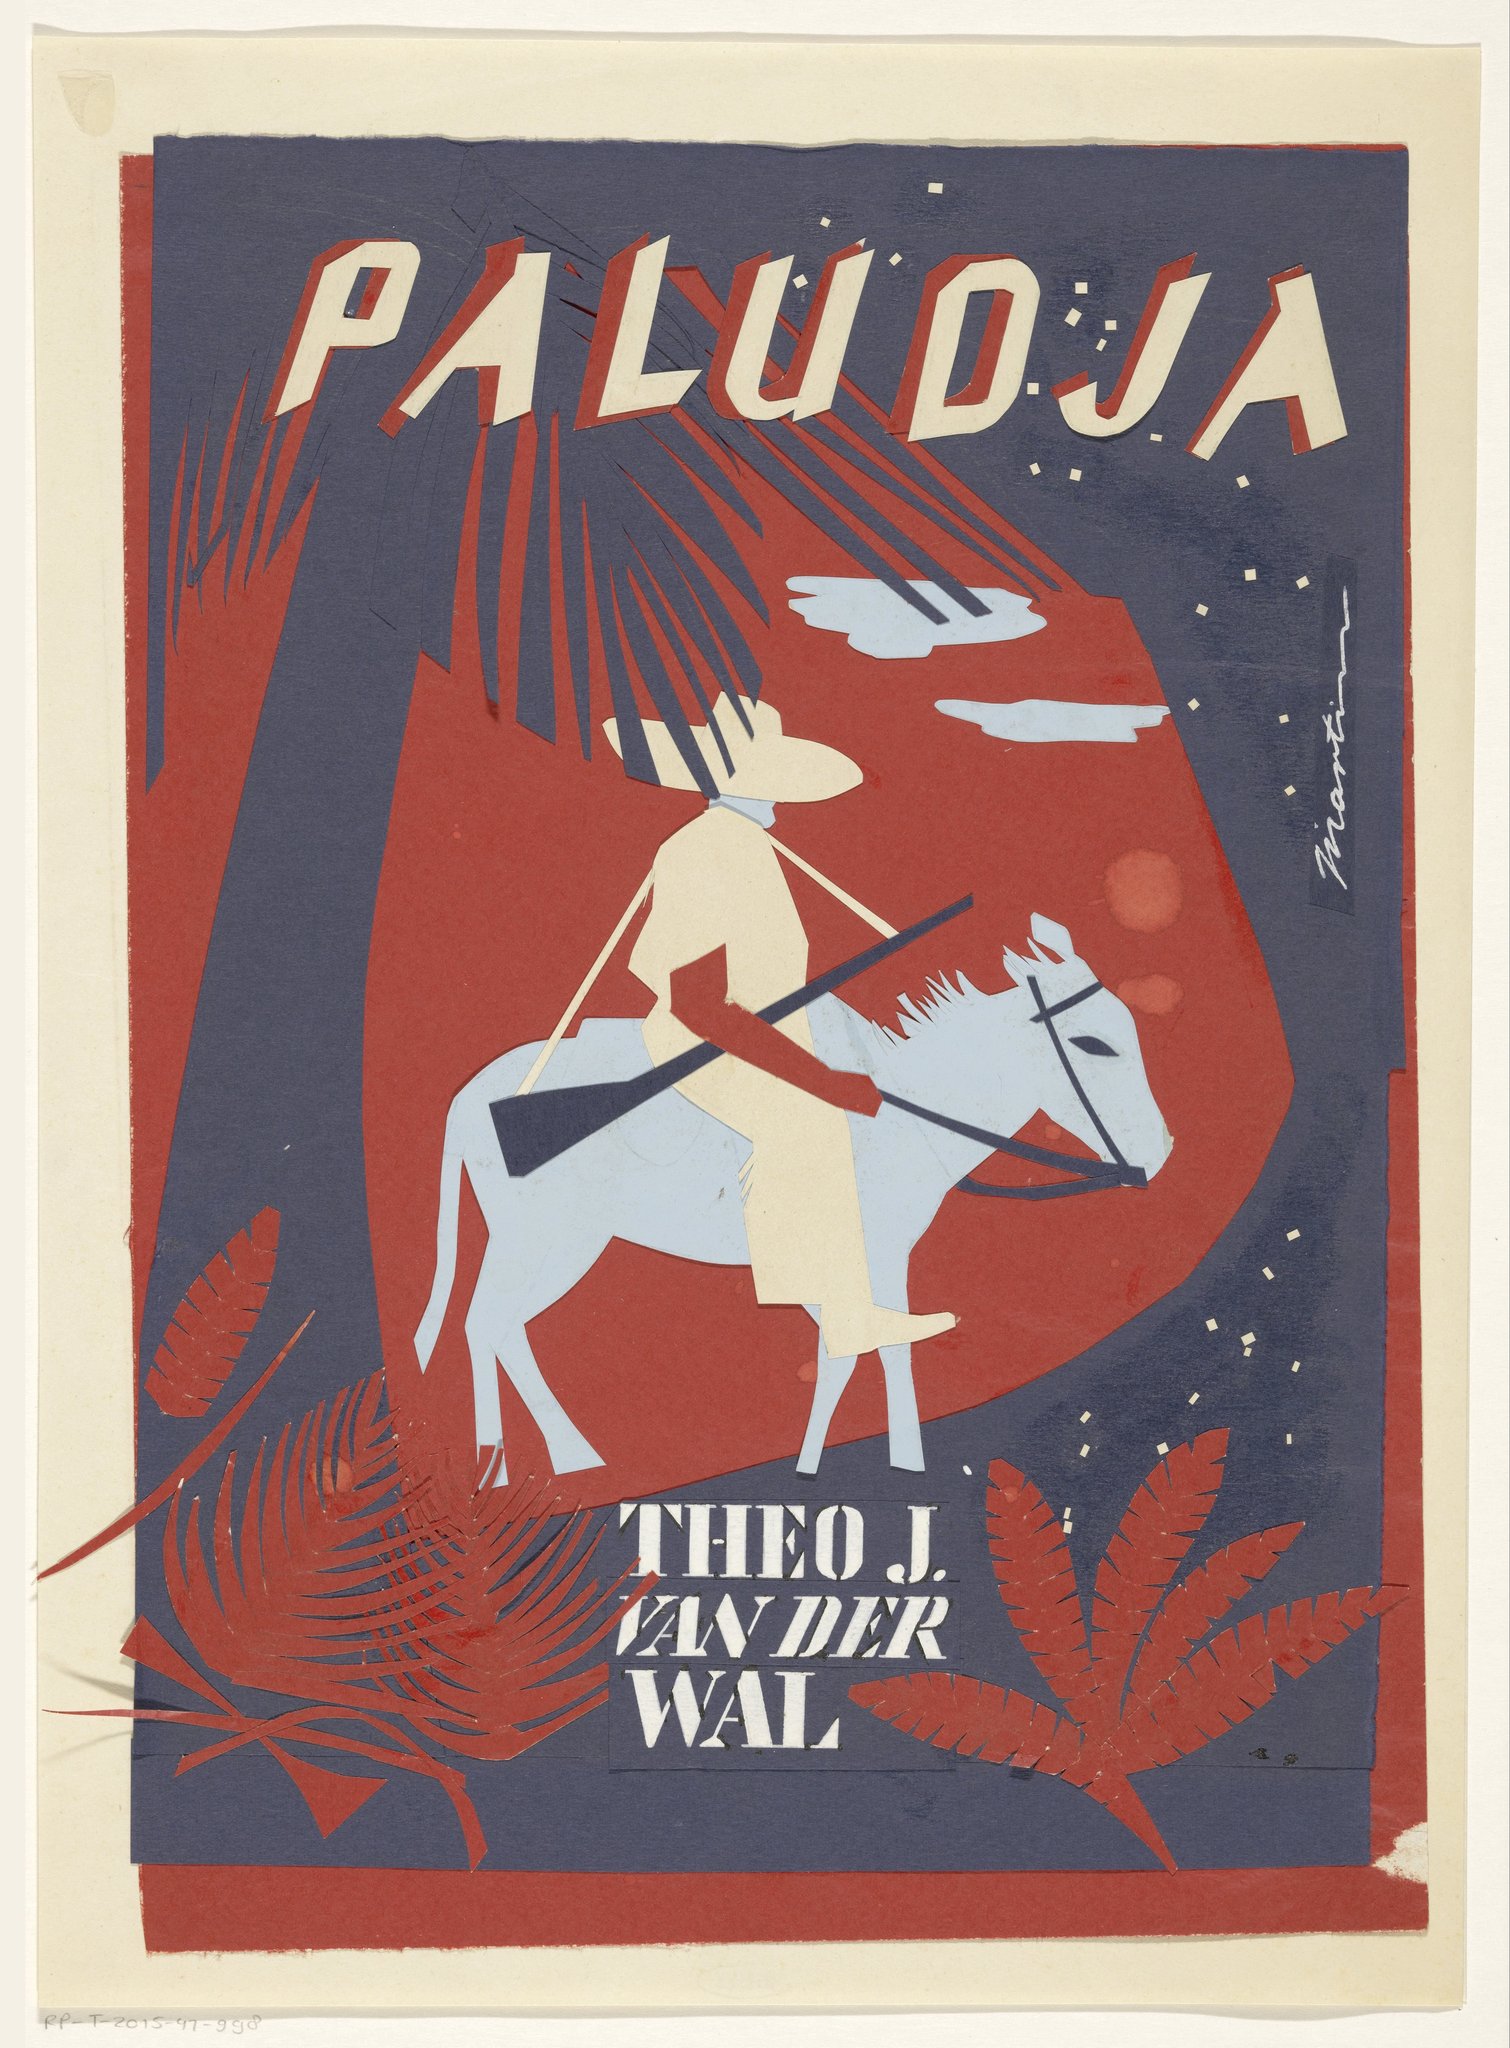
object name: collage visual work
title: Bandontwerp voor: Theo J. van der Wal, Paludja, jaar onbekend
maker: martin horwitz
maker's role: print maker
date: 1930-1965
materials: paint, ink, paper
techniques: brush, collage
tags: riding a horse, ass, or mule; rider, horseman, cowboy, firearms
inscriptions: collector's mark: Lugt 2228, name: ‘MARTIN HORWITZ/ VAN BREESTR. 110 II/ A'DAM’, signature: ‘Martin’, number:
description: Een cowboy te paard met een geweer aan een band over zijn schouder. De man rijdt onder een boom door. Op de voorgrond planten en struiken.